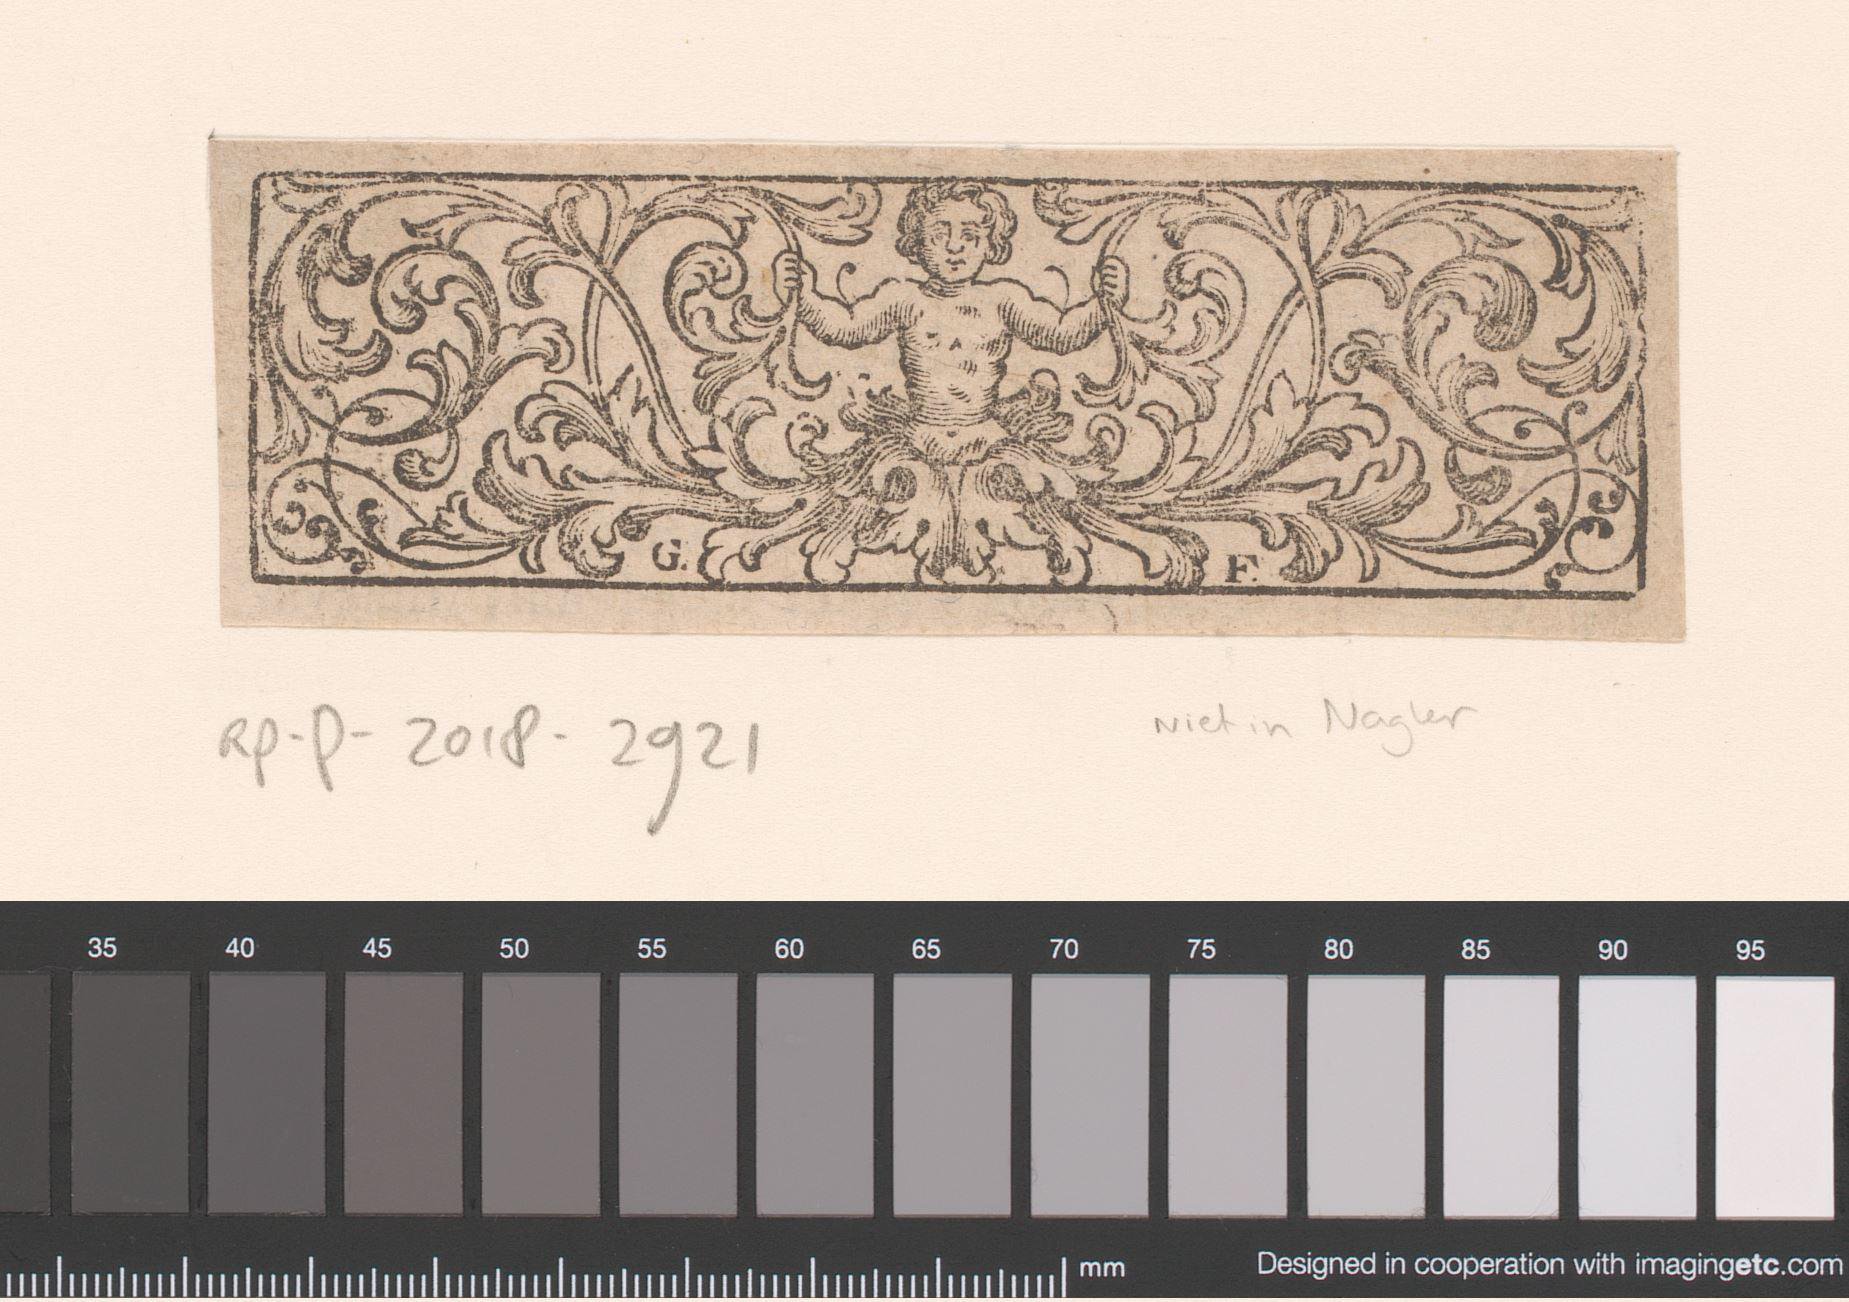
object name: print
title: Ornament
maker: Anonymous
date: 1500-1599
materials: paper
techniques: woodcut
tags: anthropomorphic ornament